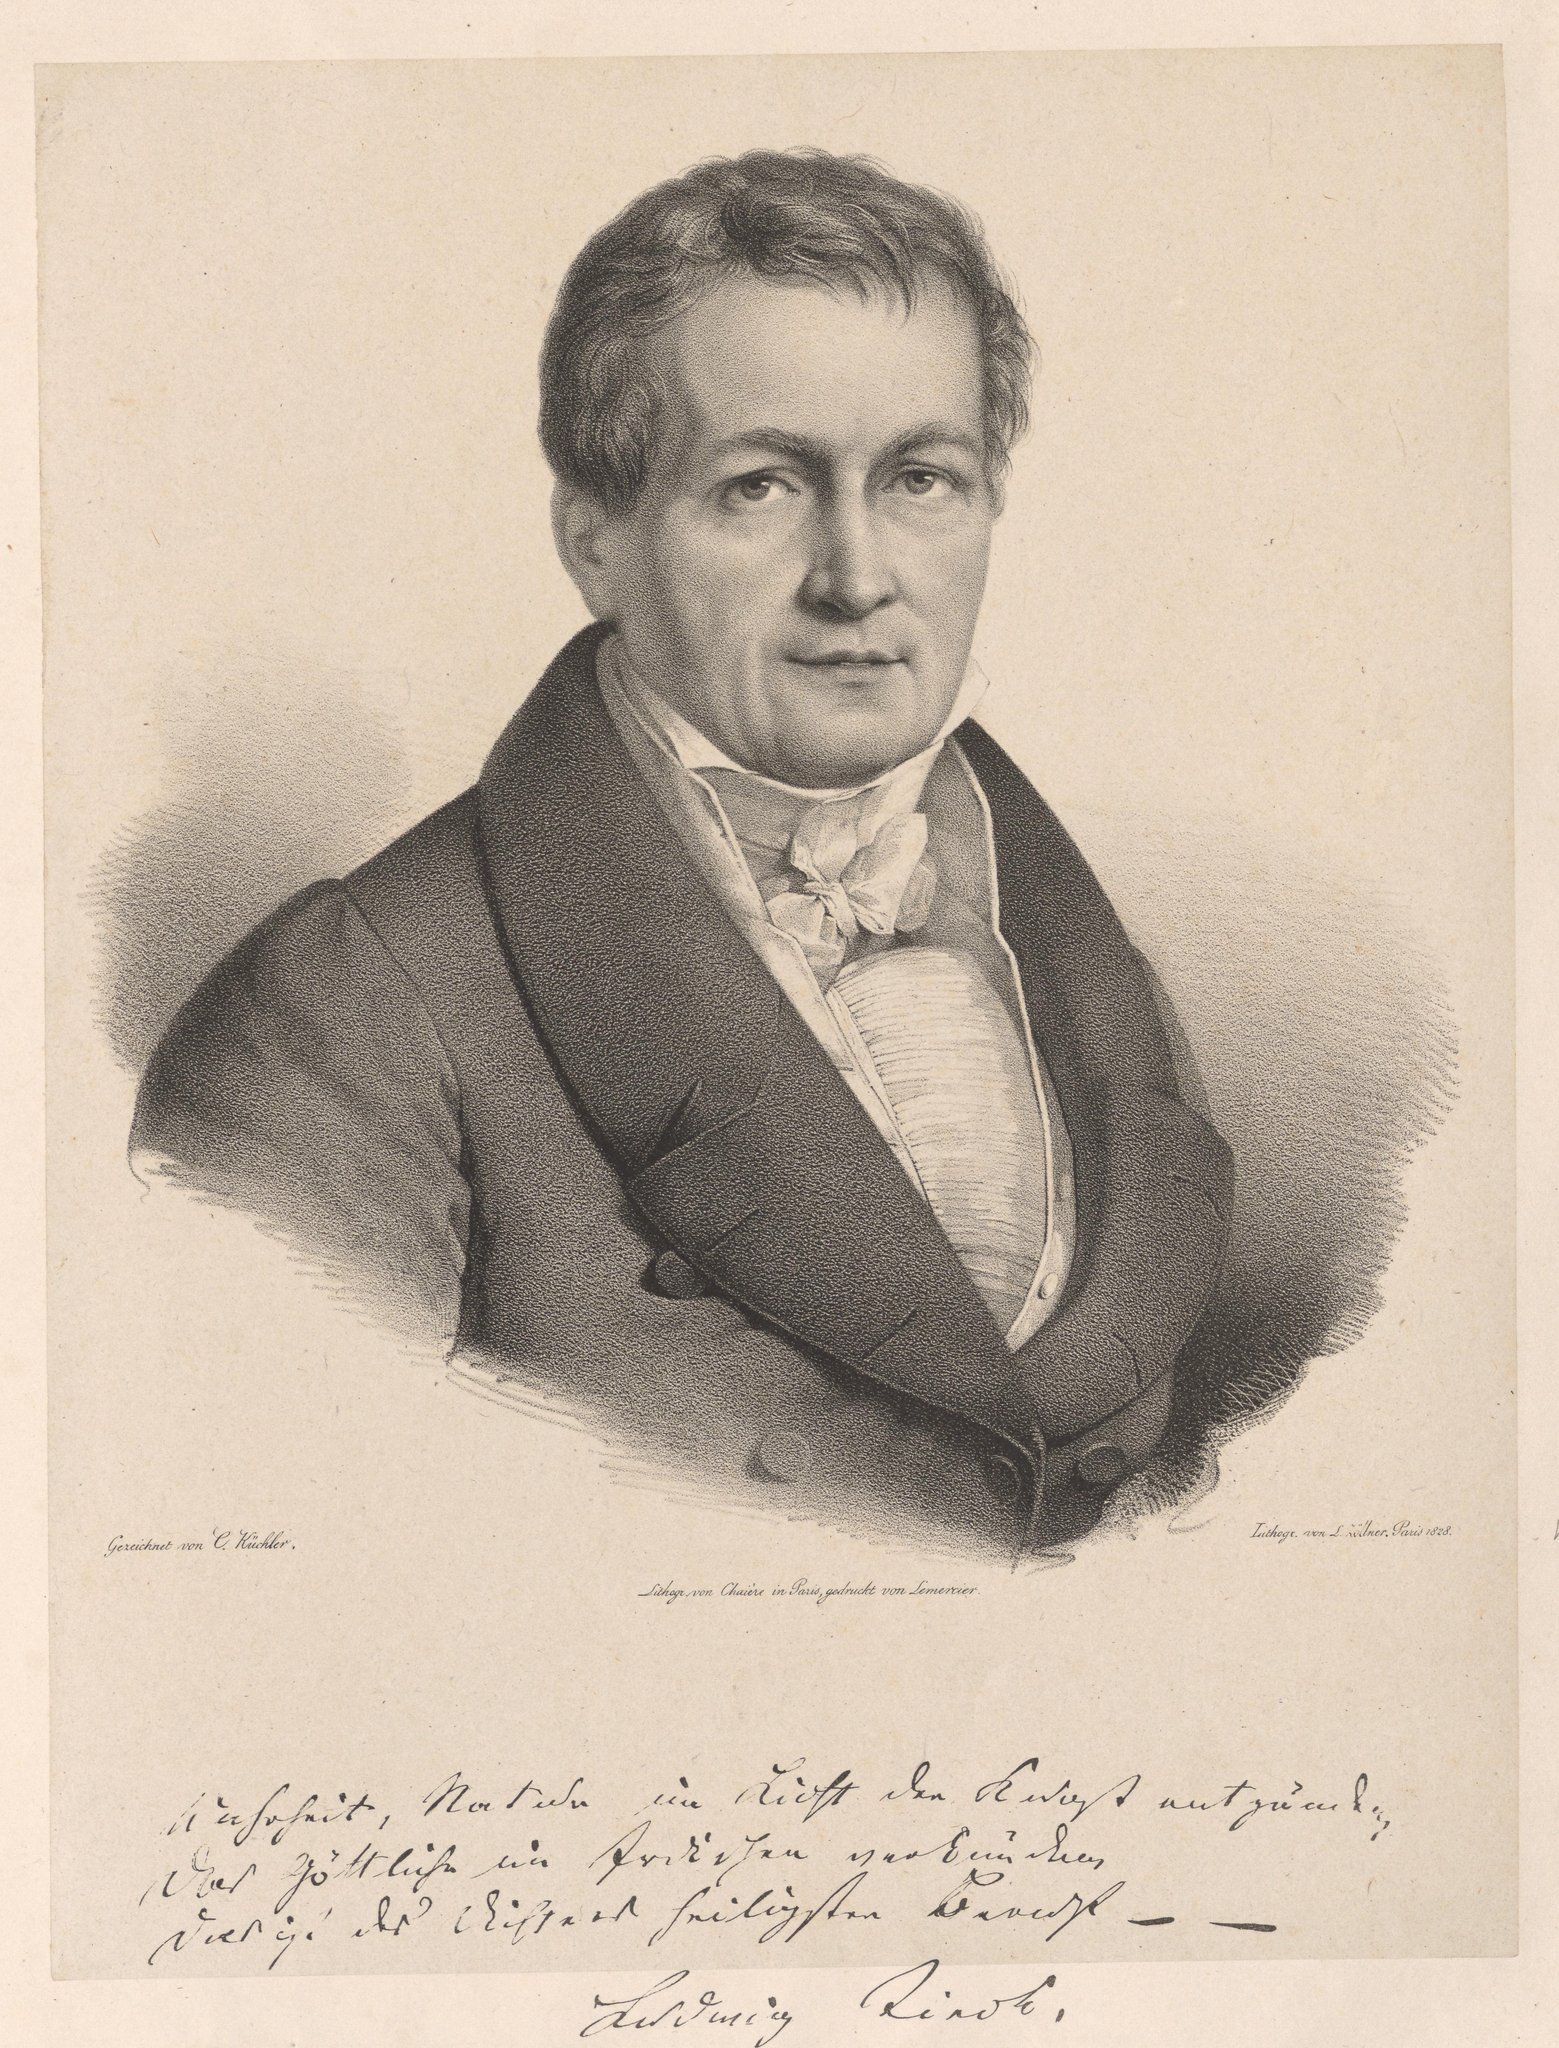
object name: print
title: Portret van Ludwig Tieck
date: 1828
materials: paper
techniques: lithograph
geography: paris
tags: berlin, historical persons, portrait of a writer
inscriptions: date